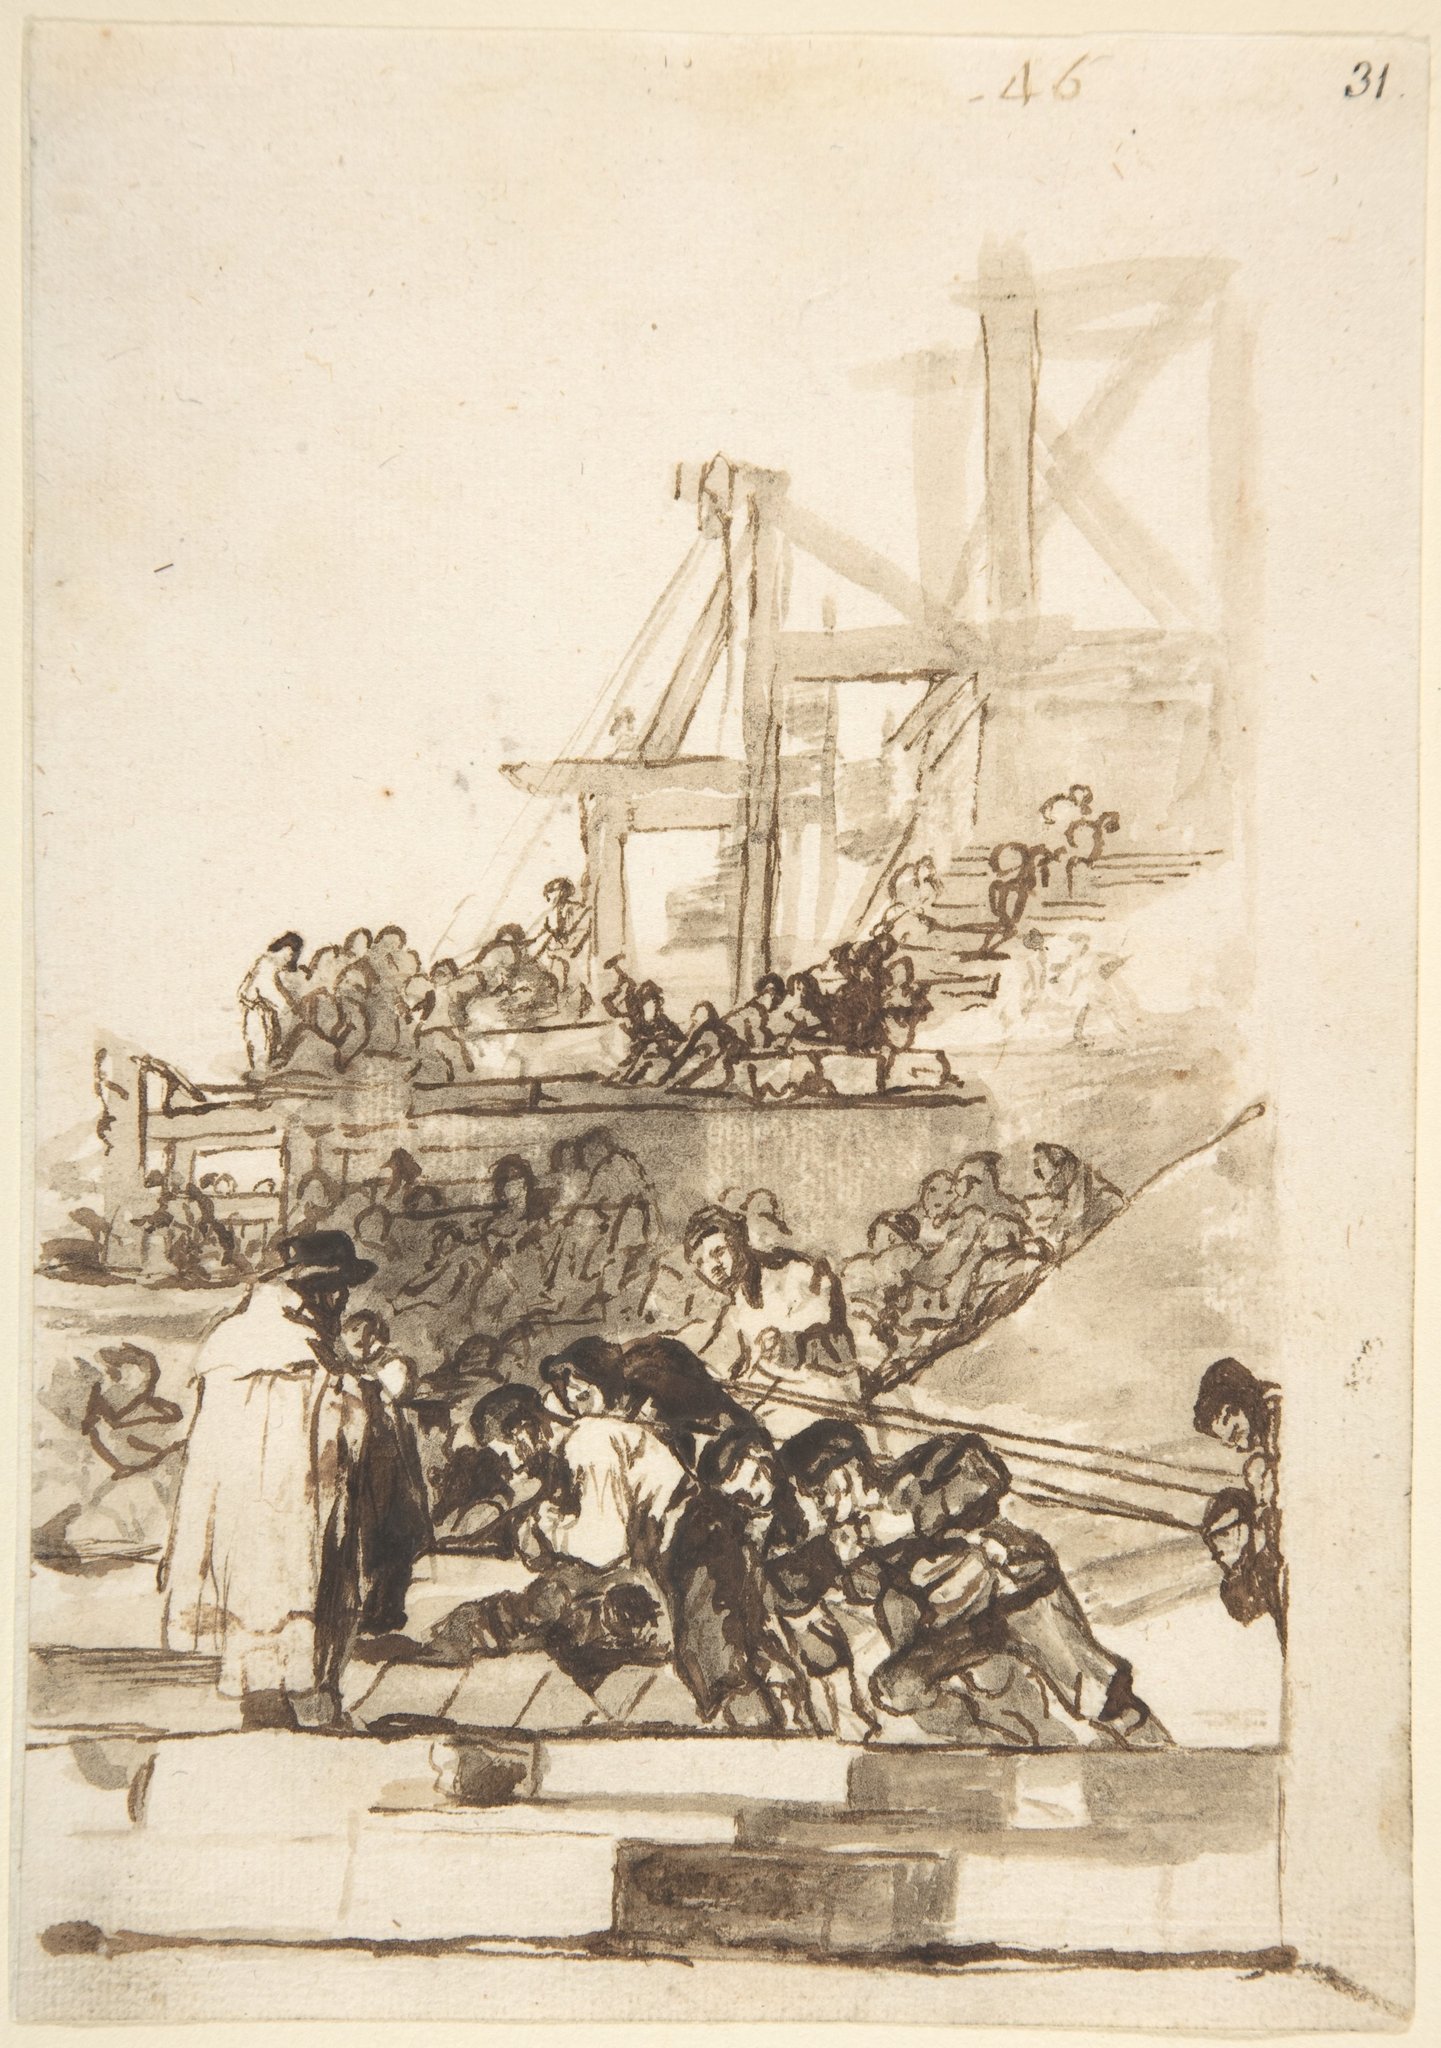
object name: drawing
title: Construction; page 46, from "Images of Spain" Album (F)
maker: goya (francisco de goya y lucientes)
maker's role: artist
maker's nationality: spanish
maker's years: 1746-1828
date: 1812-1820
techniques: brush, scraping, wash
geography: spain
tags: crowd